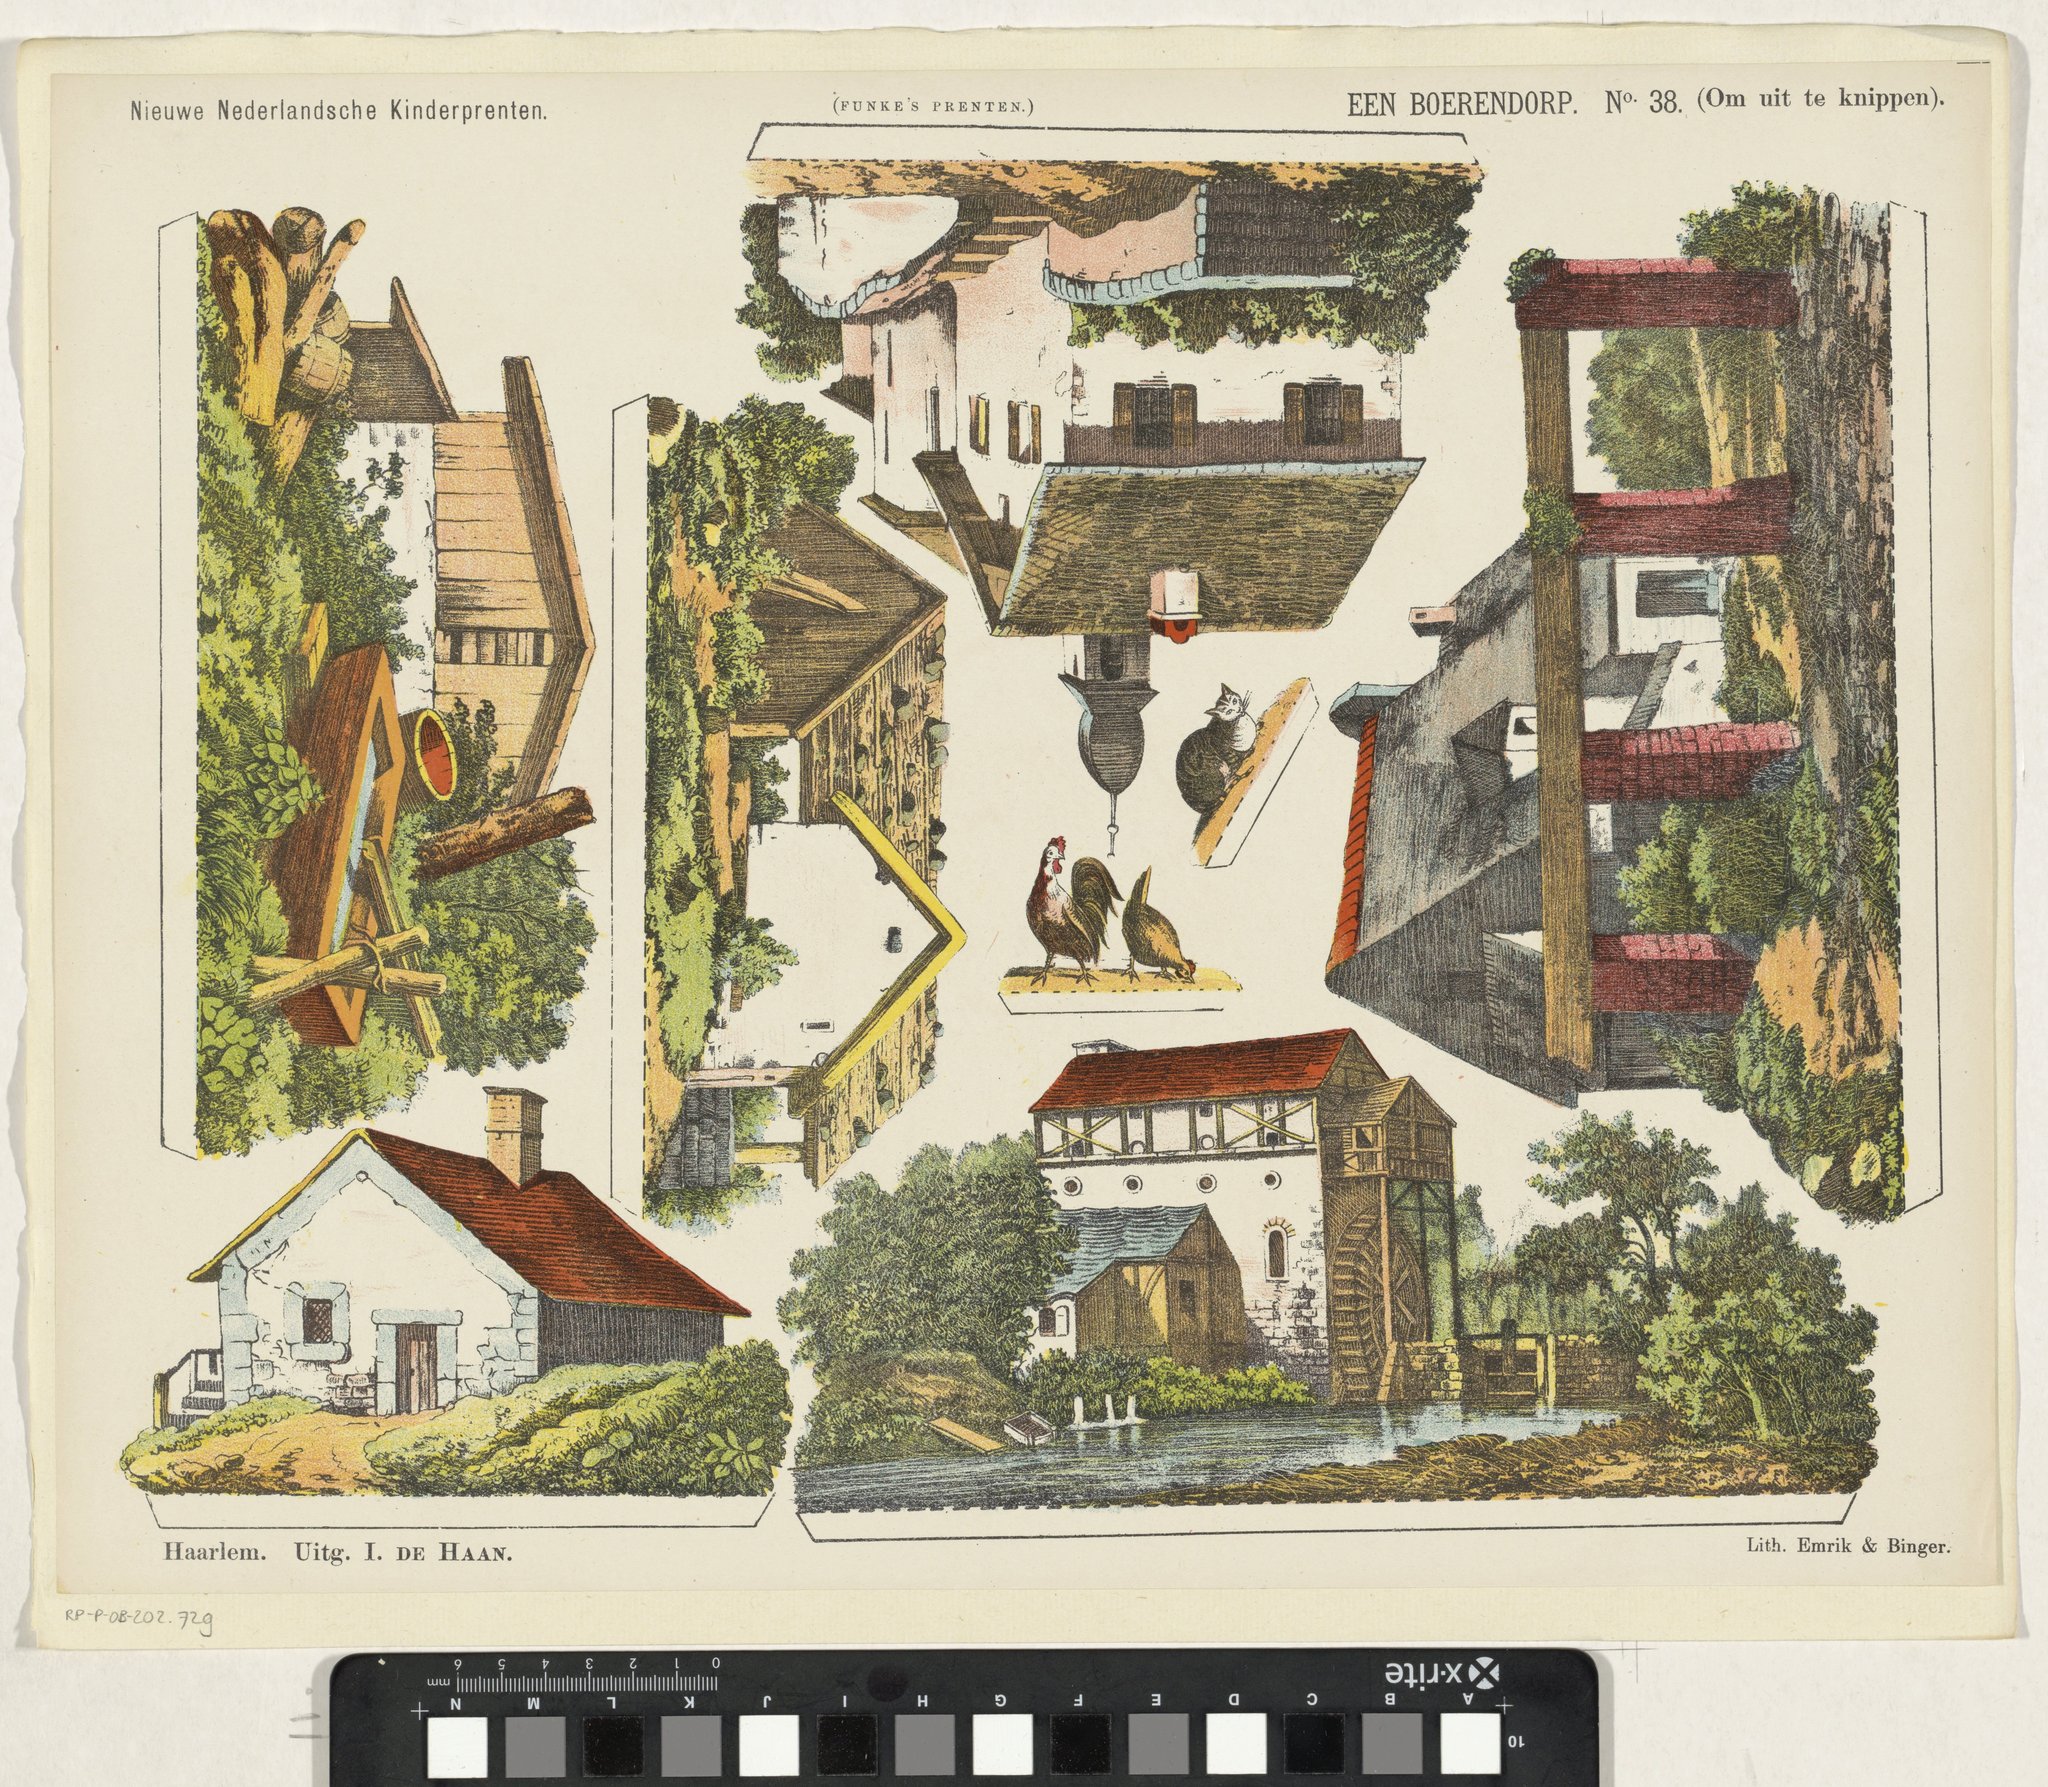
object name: print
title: Nieuwe Nederlandsche kinderprenten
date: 1875-1903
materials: paper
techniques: lithograph, letterpress printing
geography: haarlem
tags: cat, fowl (cock, hen, chicken, etc.), farm (building)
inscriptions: collector's mark: Lugt 2760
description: Blad met 8 voorstellingen van boerderijen, een kip, een haan en een kat om uit te knippen. Genummerd rechtsboven: No. 38.